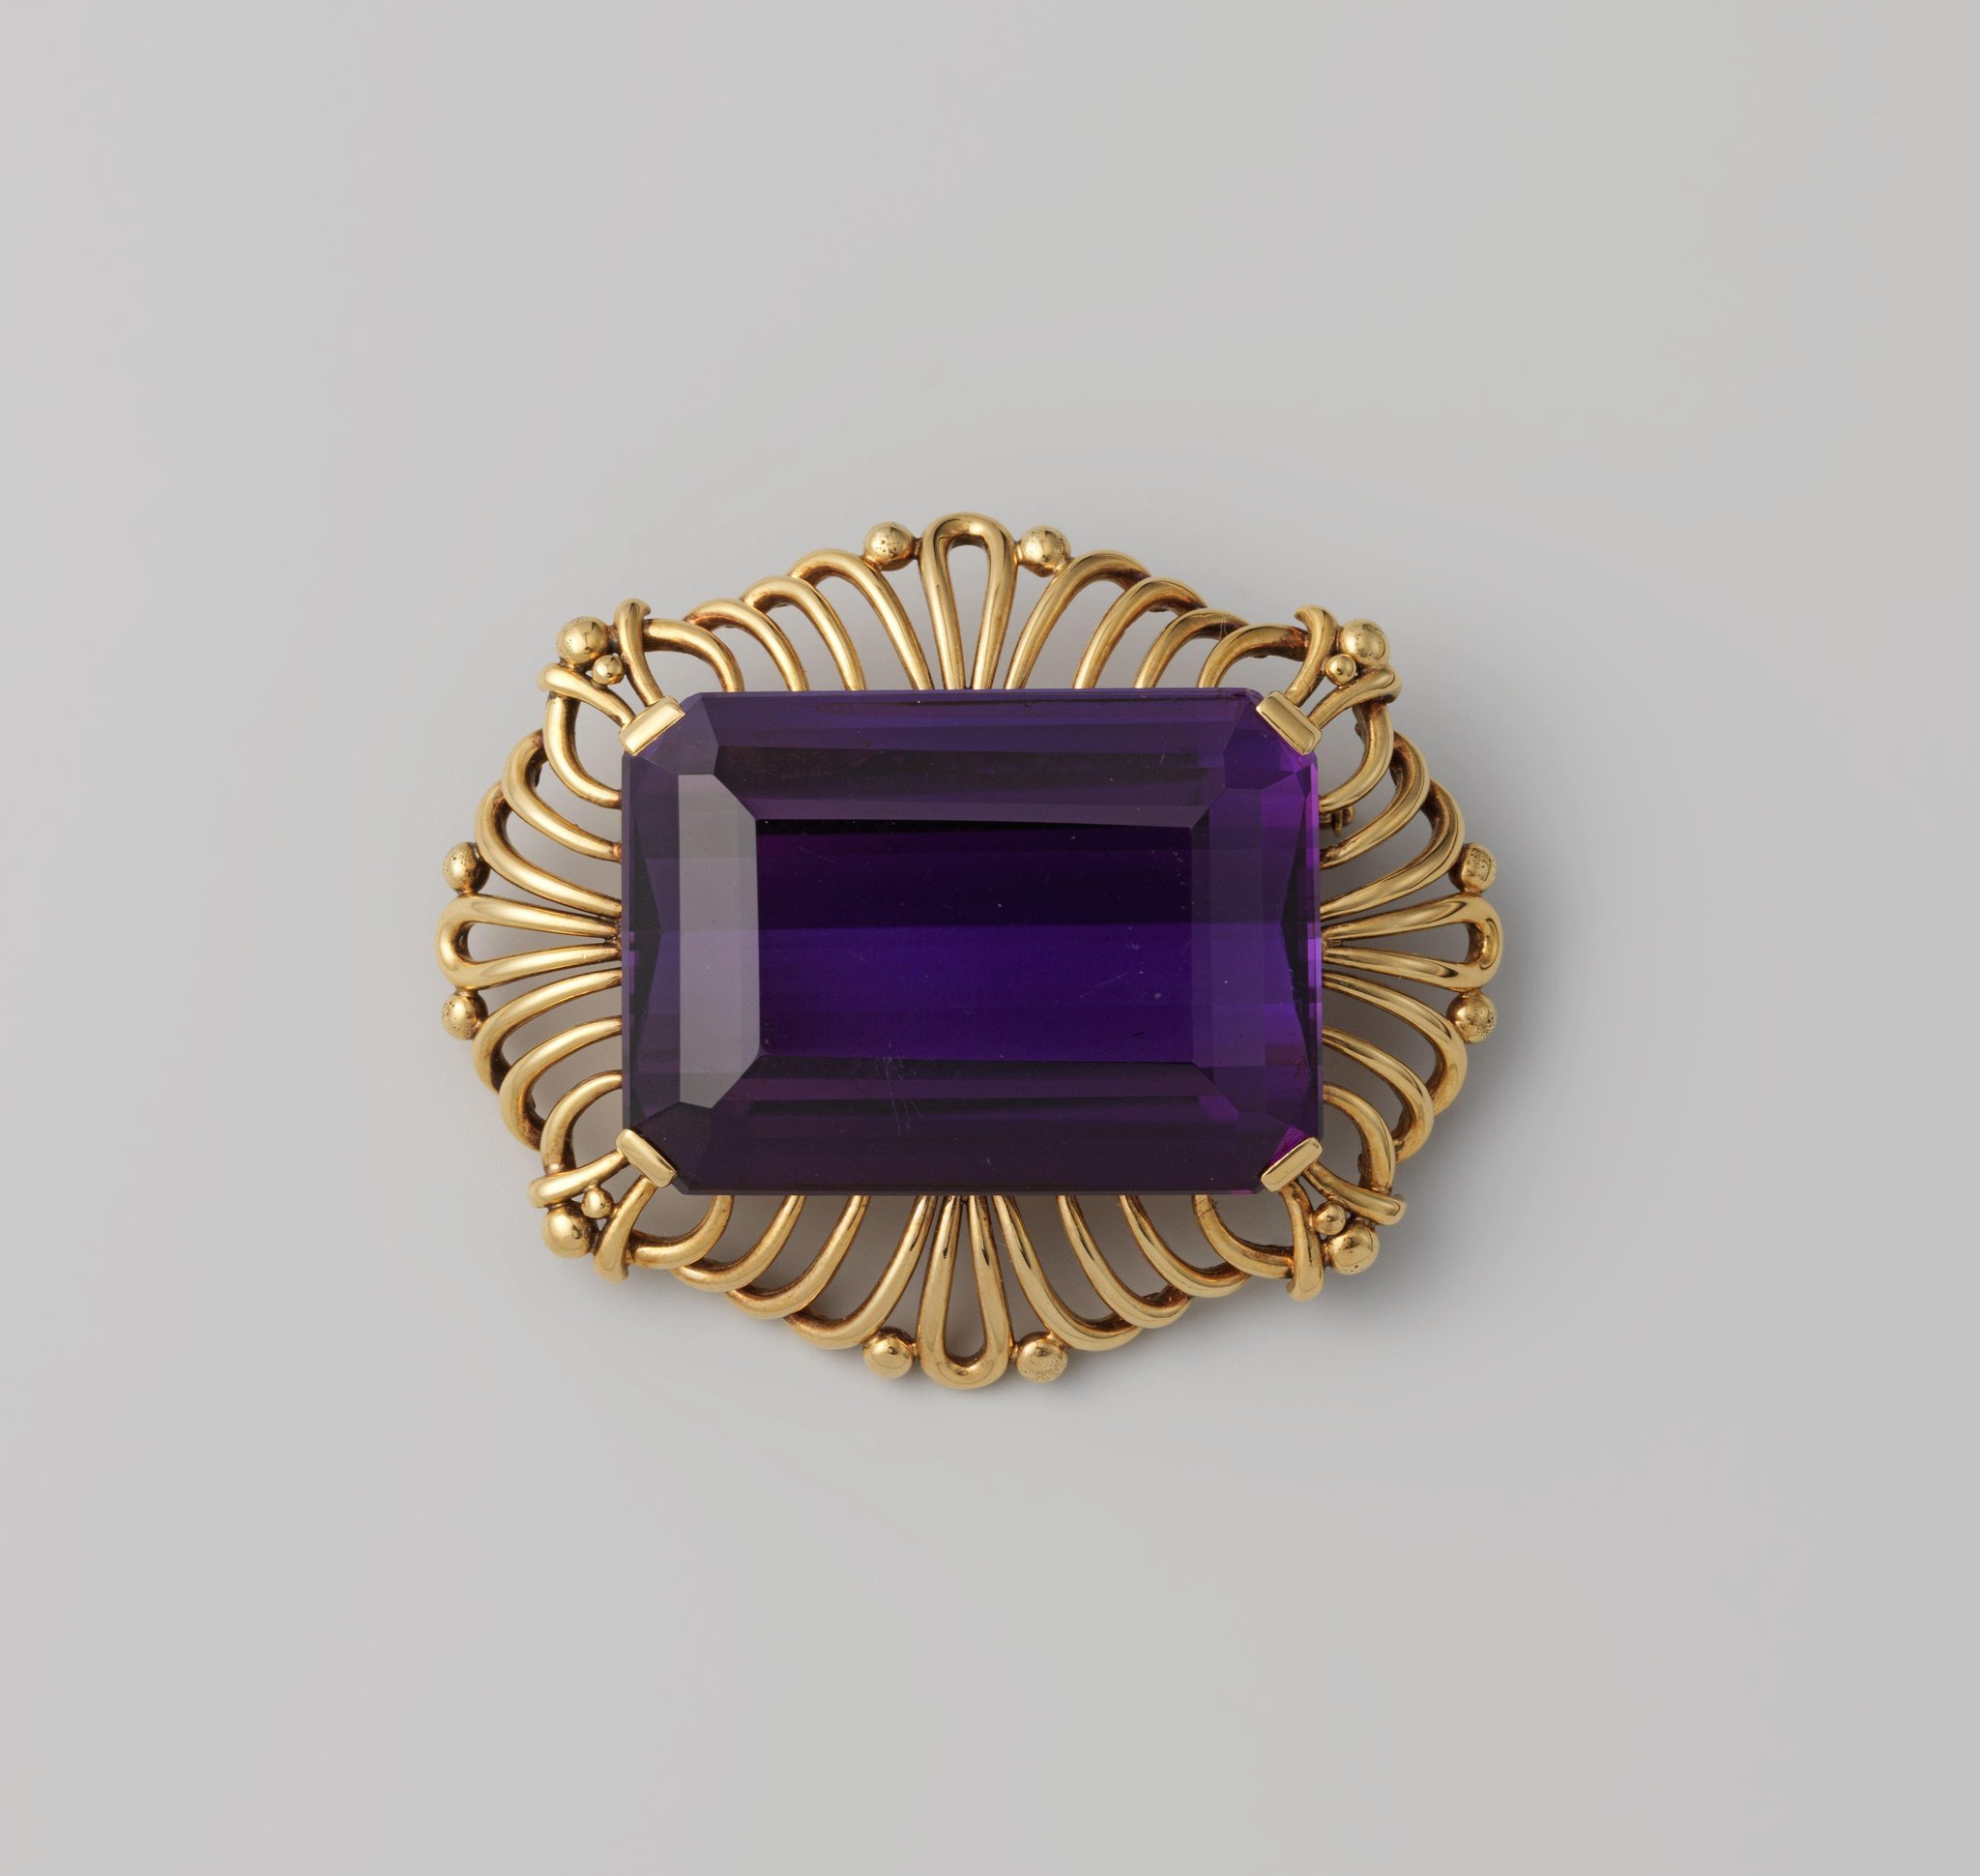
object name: brooch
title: Broche van gouddraad met amethist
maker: jan hessing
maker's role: juwelier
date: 1953-1963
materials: gemstone, gold thread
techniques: faceting, grinding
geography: voorburg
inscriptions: alloy mark: ‘eikenblad 585’, maker's mark: ‘J.H2’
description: Broche van gouddraad met rechthoekige gefacetteerde liggende amethist voorzien van een kanonsluiting.